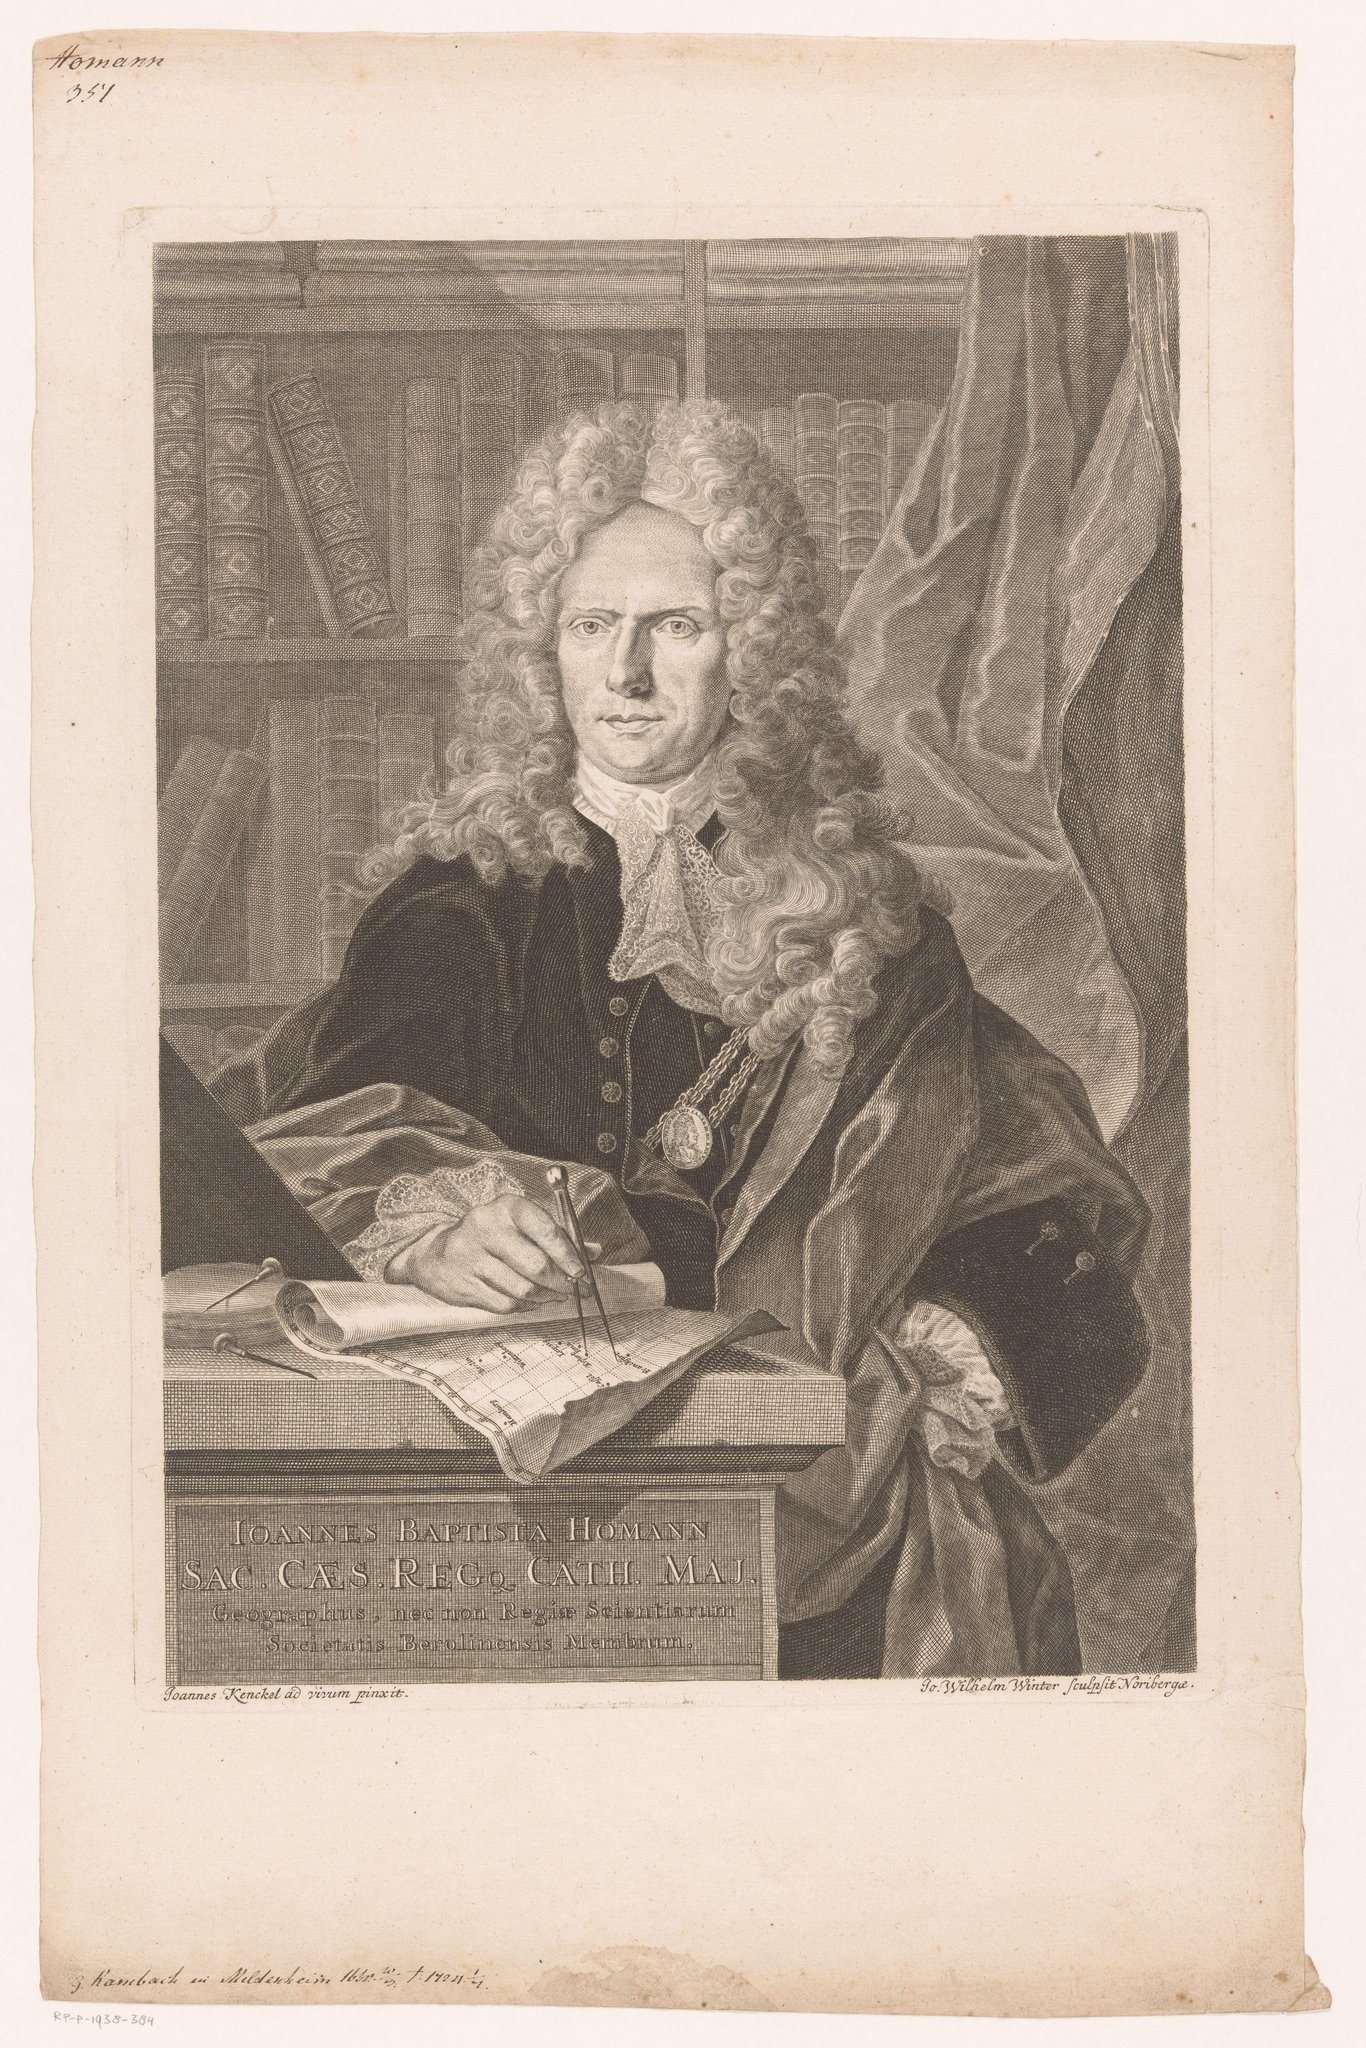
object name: print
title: Portret van Johann Baptist Homann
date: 1706-1765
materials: paper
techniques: engraving, etching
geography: nuremberg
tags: print maker, publisher, bookshelves, historical persons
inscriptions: inscription: ‘G. hambach in Mildenheim 1664 20/3 1724 1/7’, collector's mark: Lugt 2228, inscription: ‘Homann 351’